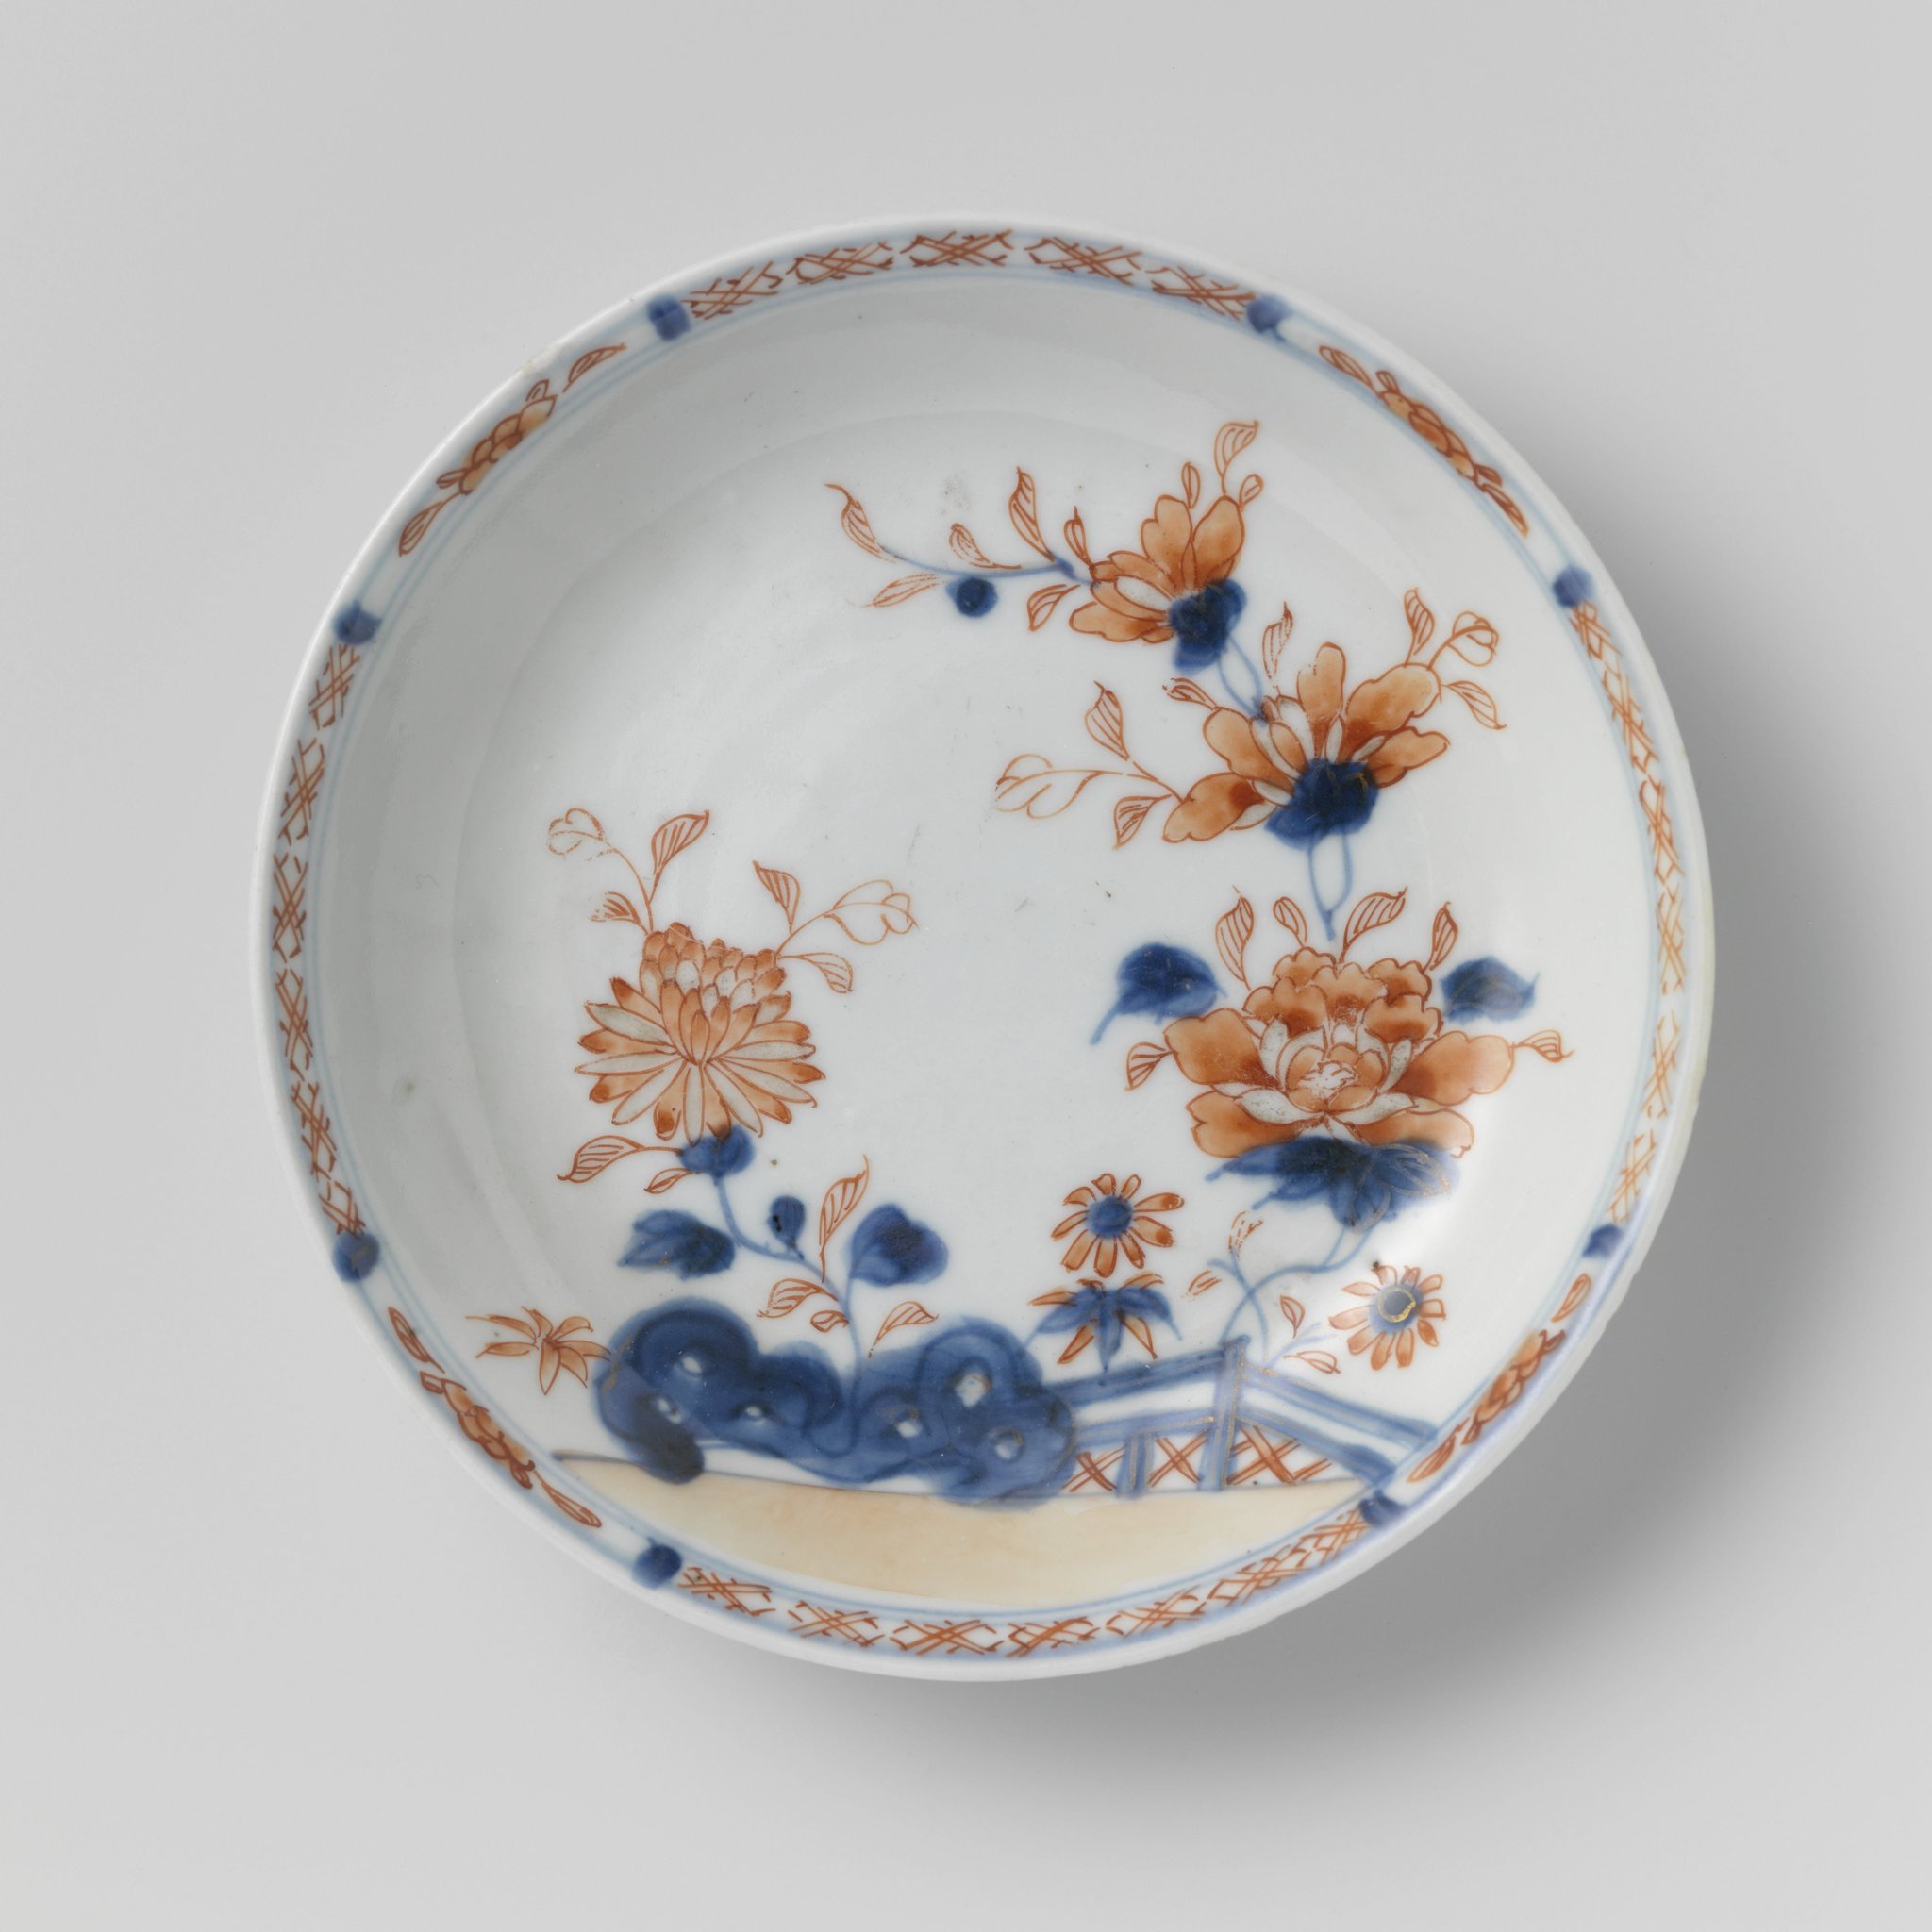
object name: kop en schotel, kop en schotel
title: Saucer with flower sprays behind a rock and fence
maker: Anonymous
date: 1750-1774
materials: cobalt, glaze, gold, paint, porcelain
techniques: firing, gilding, turning, vitrification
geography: china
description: Schotel van porselein, beschilderd in onderglazuur blauw en op het glazuur rood en goud. Op het plat van de schotel grote, bloeiende planten (pioen, chrysant, aster) achter een rots en een hekje; de rand met servetwerk afgewisseld met een bloemtak in een cartouche. Chinees Imari.